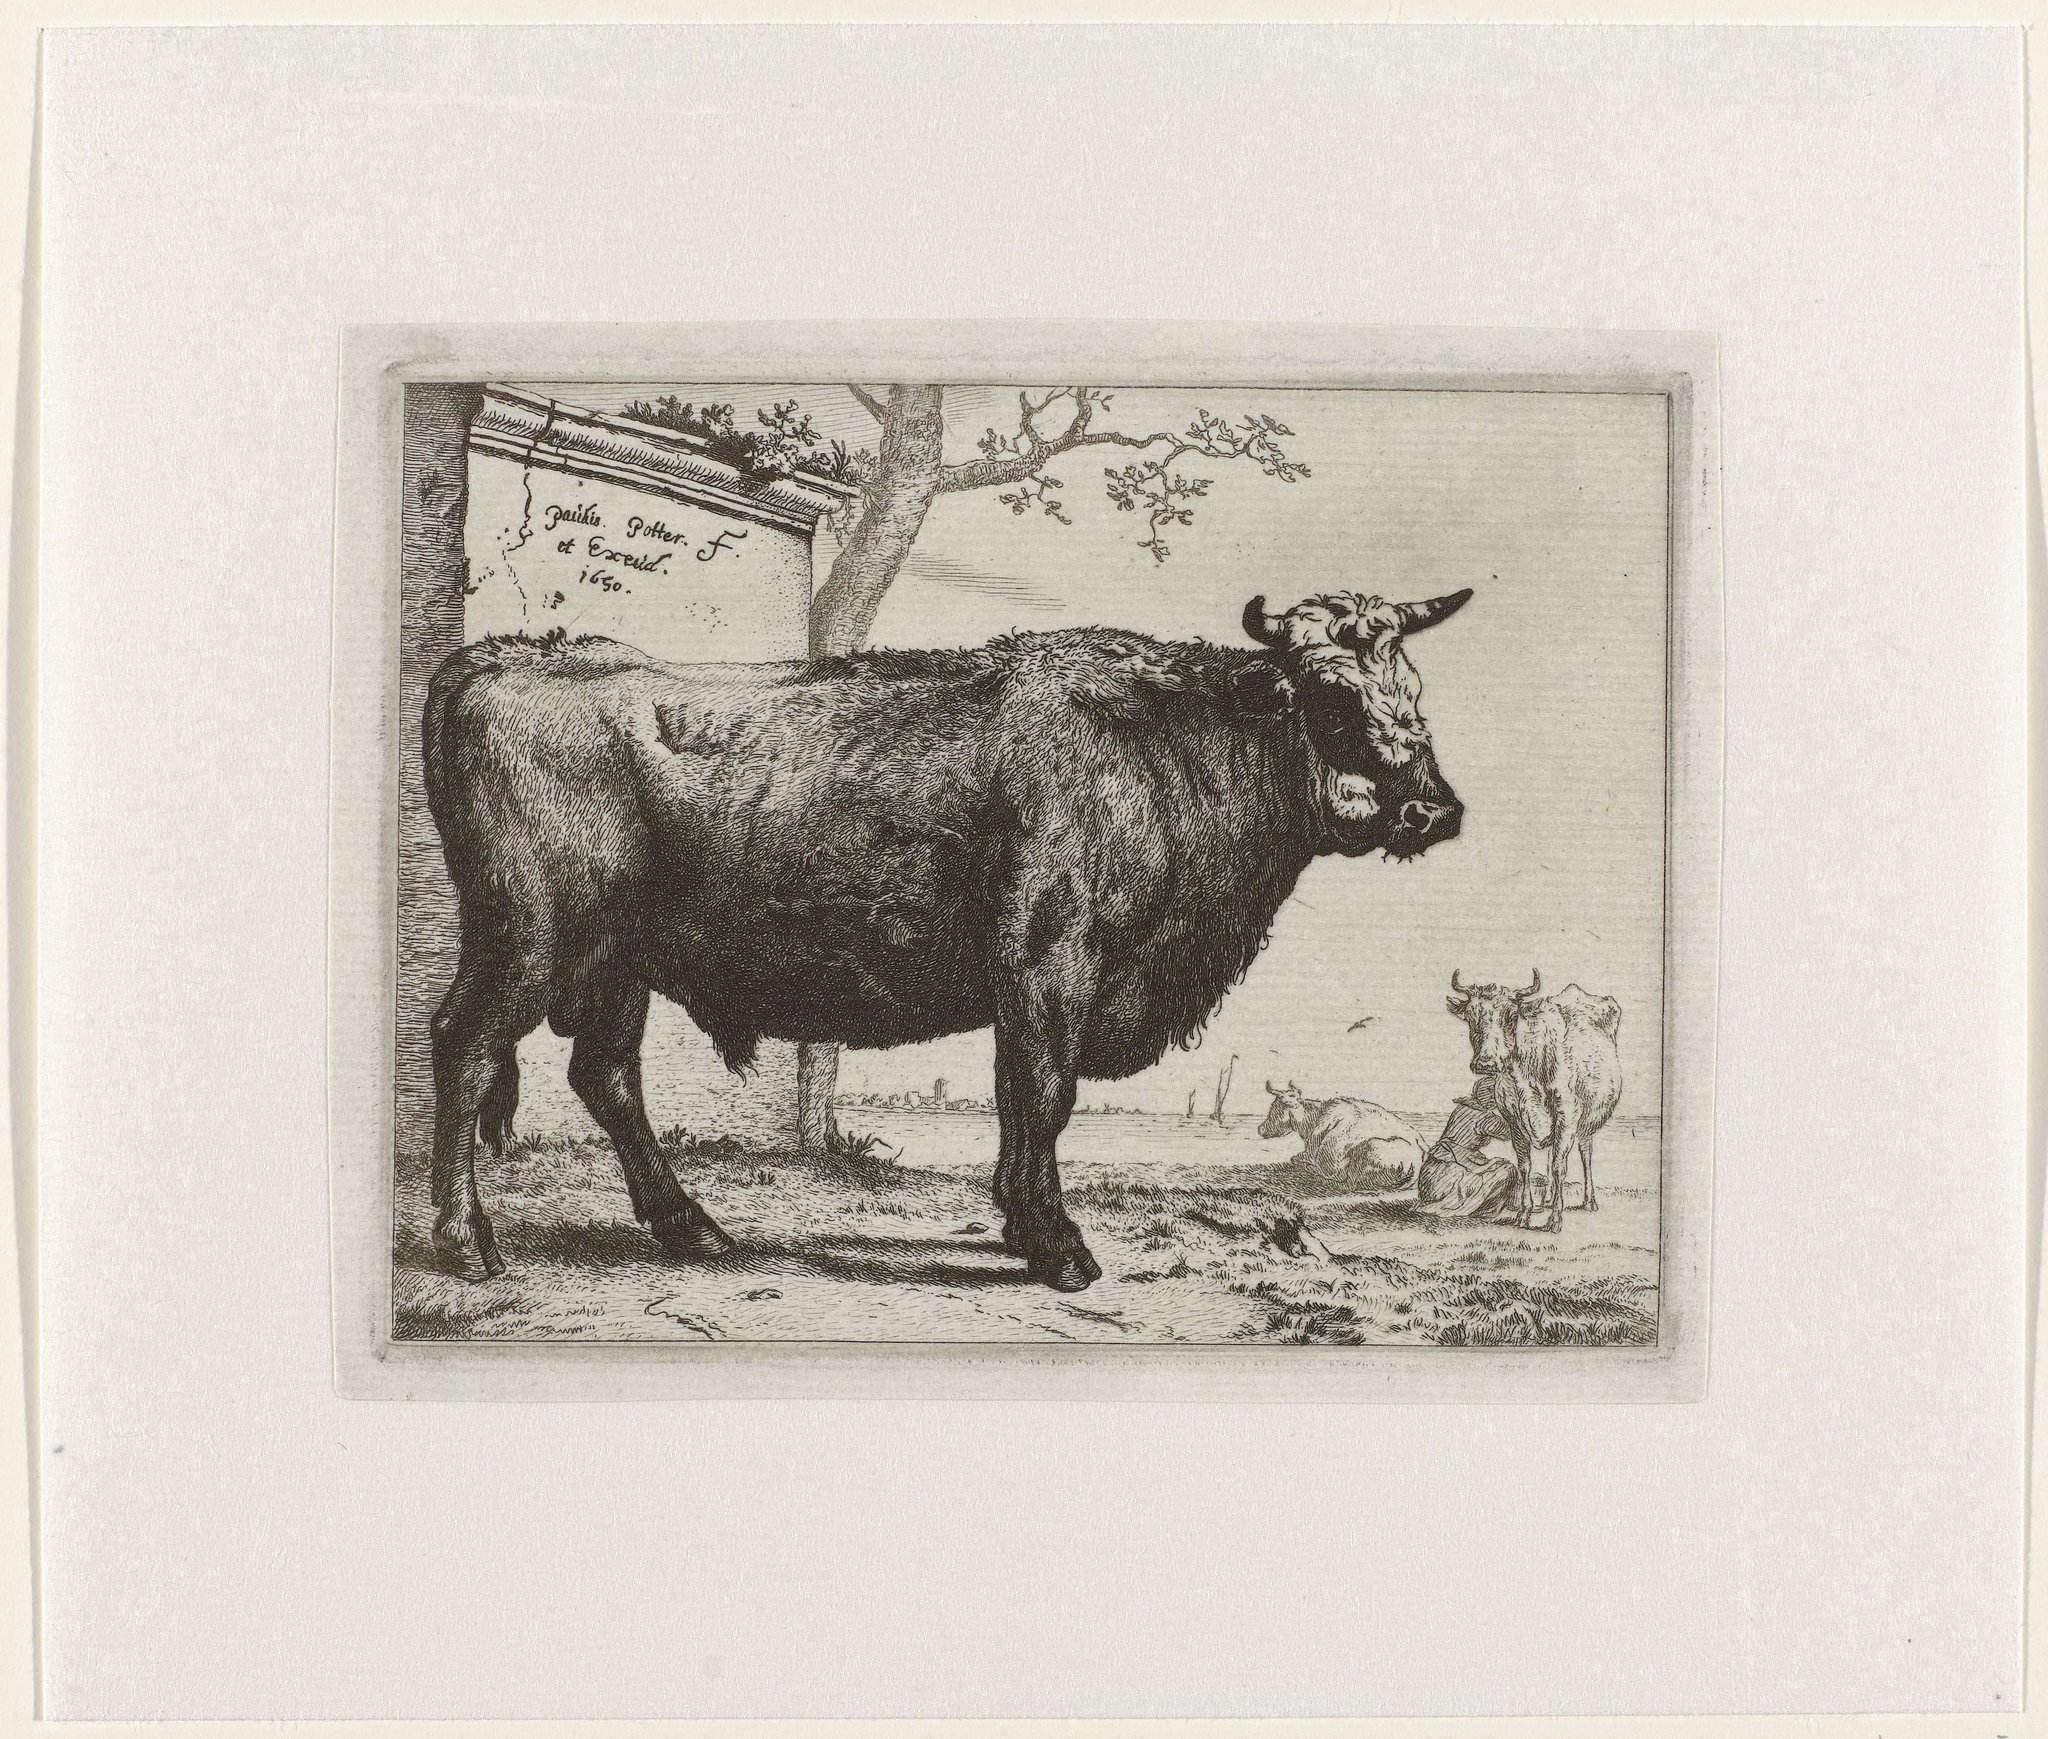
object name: print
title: Stier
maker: Anonymous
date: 1650-1700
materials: paper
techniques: etching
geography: netherlands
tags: bull, milking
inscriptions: collector's mark: Lugt 2228, collector's mark: Lugt 2760, number: ‘931’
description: Landschap met een blaarkopstier. Rechts op de achtergrond twee koeien, waarvan er één wordt gemolken door een meisje. Op de achtergrond een meer en een gezicht op een dorp.